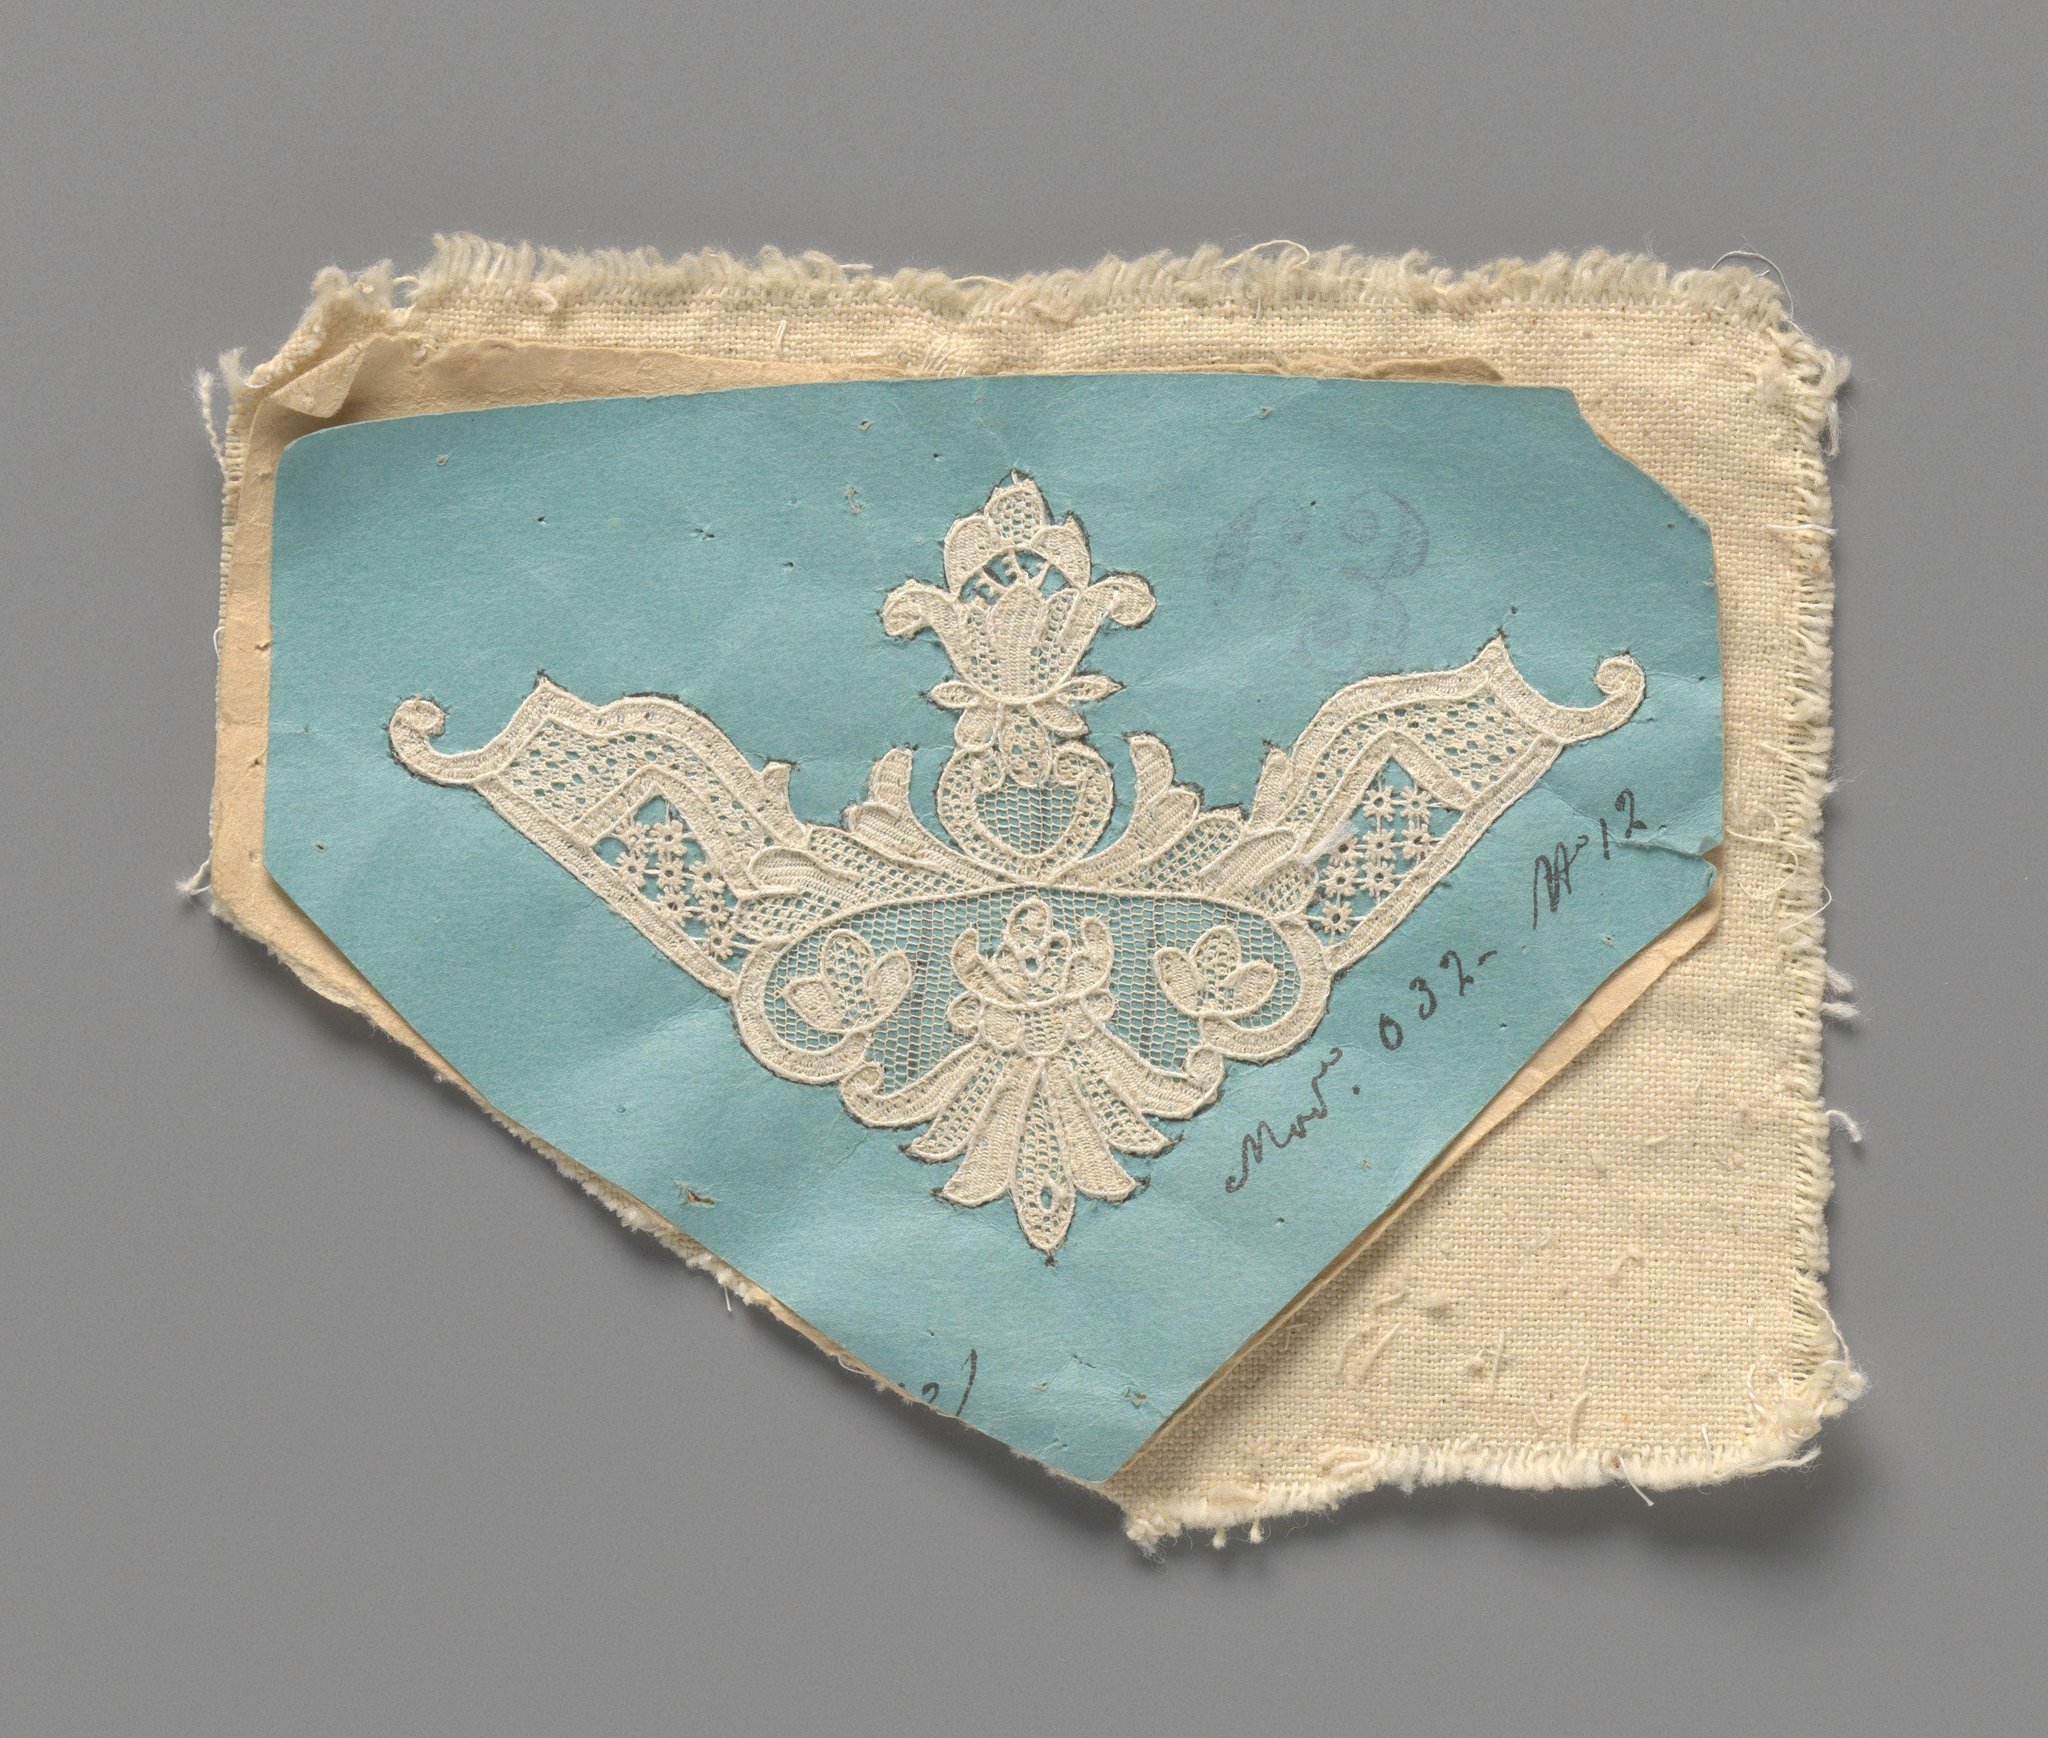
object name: werkstuk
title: Werkstuk van naaldkant dat nog losgemaakt moet worden van de tijdelijke onderlagen van papier en textiel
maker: Anonymous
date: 1925-1935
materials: cotton, linen, paper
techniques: needle lace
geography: burano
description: Werkstuk van naaldkant waarbij het kant nog aan een onderlaag van textiel en twee lagen papier vast zit. Het textiel en de onderste laag papier zijn naturelkleurig, het bovenste papier is blauw gekleurd. Er staat een stempel op '63' en de handgeschreven tekst 'mod. 032 - No 12'.